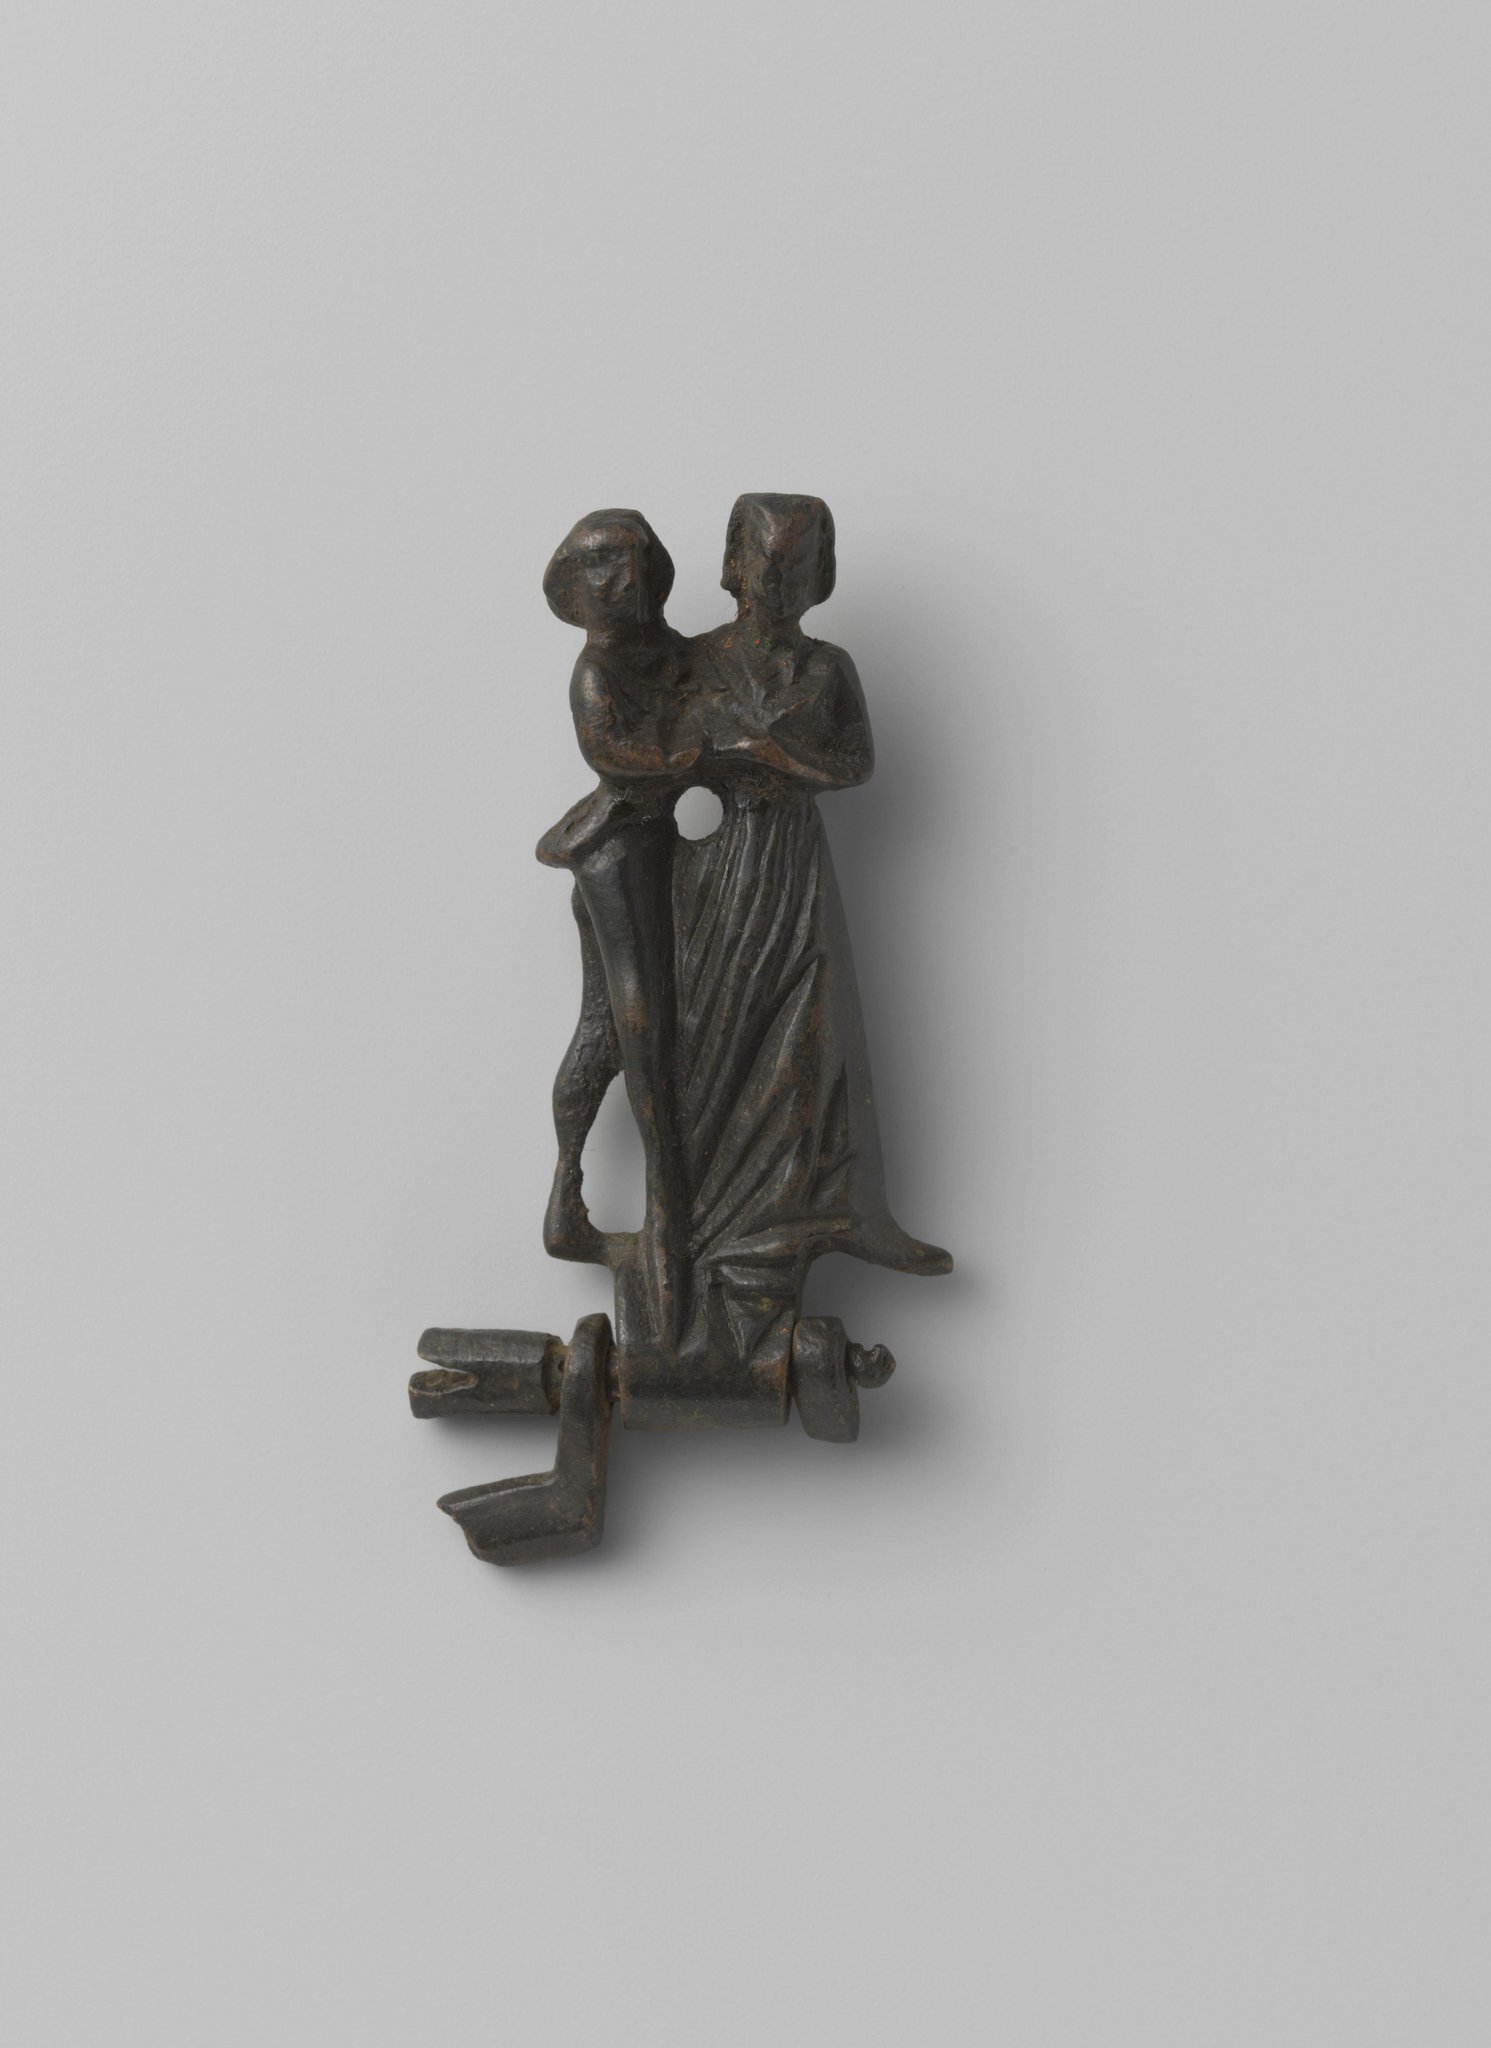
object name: beugelhaak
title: Beugelhaak in de vorm van een paar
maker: Anonymous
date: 1450-1500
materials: brass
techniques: casting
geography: nuremberg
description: Het voorwerp bestaat uit vier delen: de voorkant van de haak in de vorm van een paartje, de stift, die door het oog onderaan is gestoken, en de twee kleine stukken van de ontbrekende beugel. De haak is afgebroken.